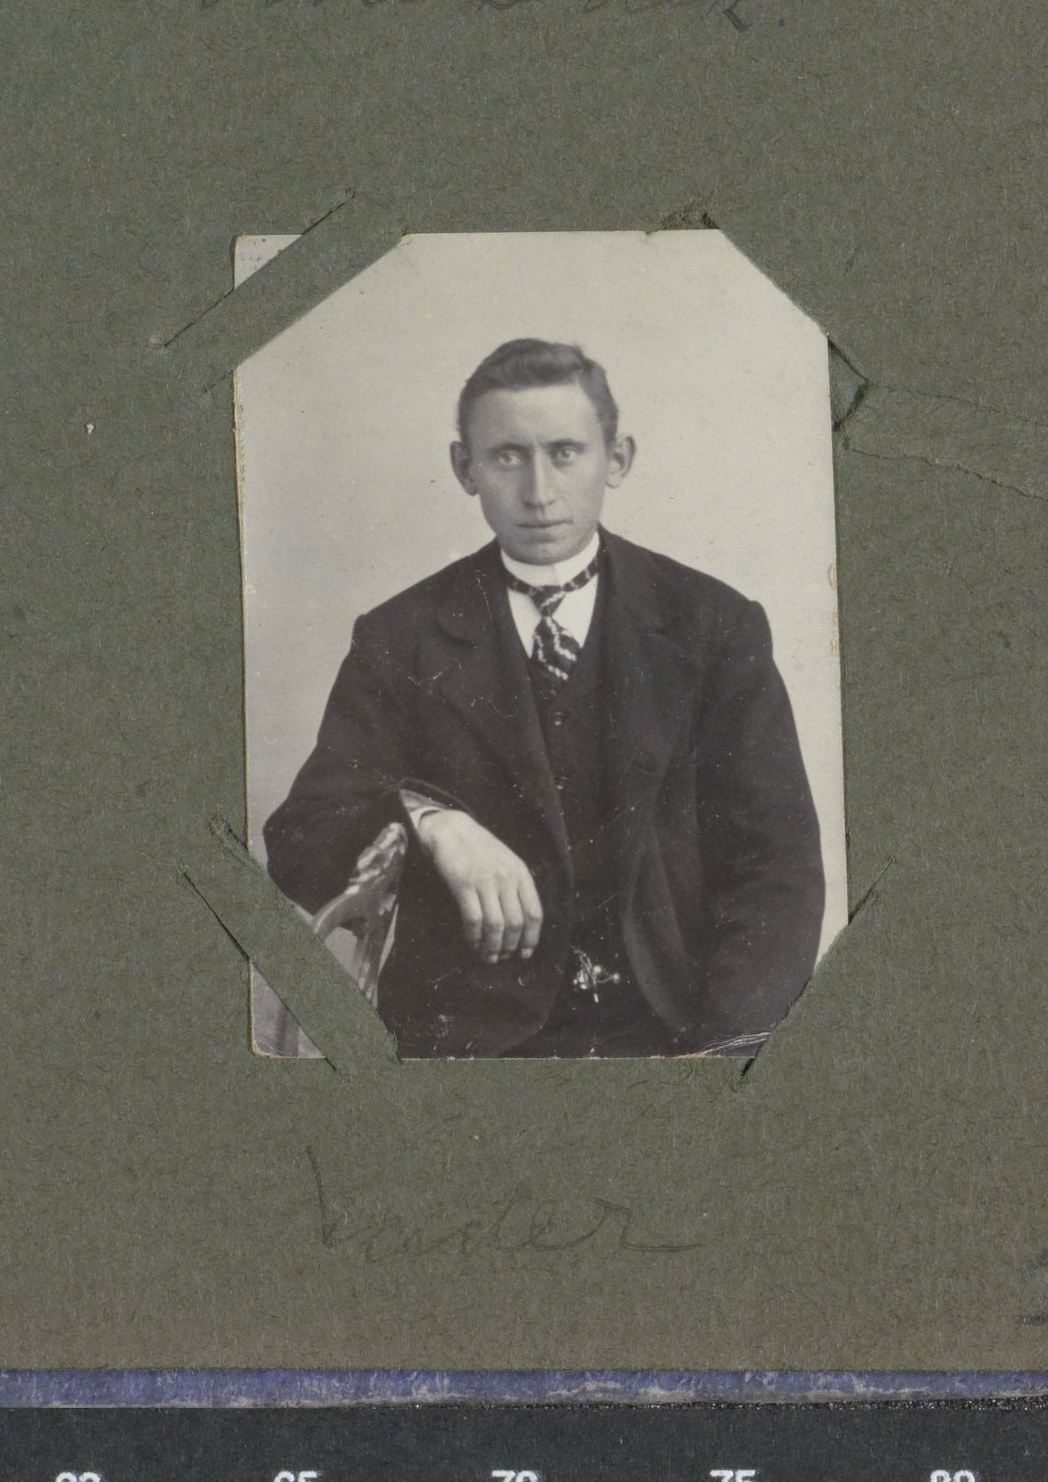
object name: photograph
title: Portret van een zittende man met een gestreepte stropdas, aangeduid als 'Vader'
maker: Anonymous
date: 1910-1920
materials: cardboard, paper, photographic support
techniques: collodion silver print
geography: netherlands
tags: adult man, historical persons, neck-gear ~ clothing, netherlands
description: Onderdeel van Album met automaatfoto's van een Nederlandse familie.